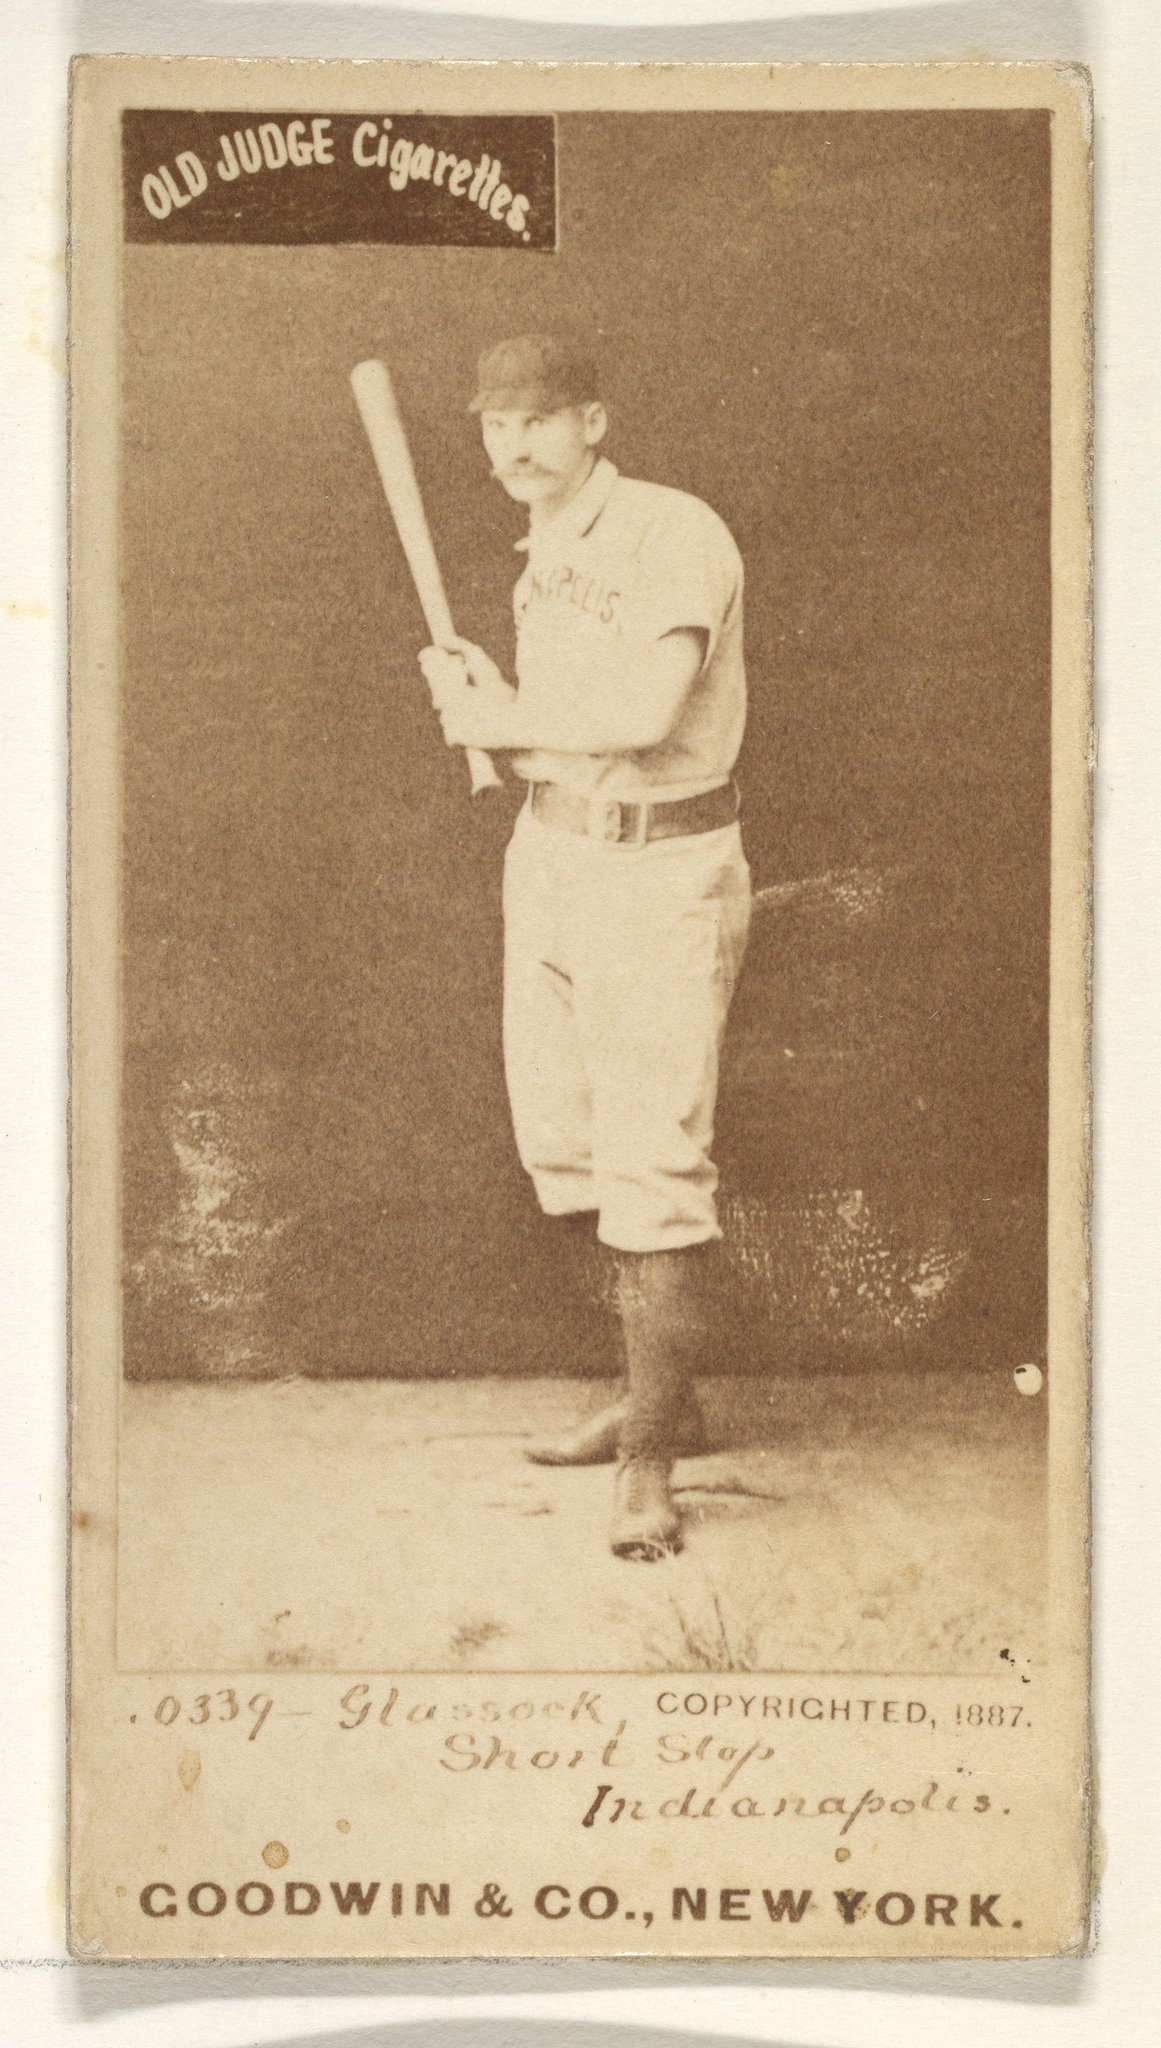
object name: baseball card, photograph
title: Glasscock, Shortstop, Indianapolis, from the Old Judge series (N172) for Old Judge Cigarettes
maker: goodwin & company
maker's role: publisher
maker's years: 1850-1950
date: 1887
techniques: albumen silver print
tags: men,portraits,baseball,athletes